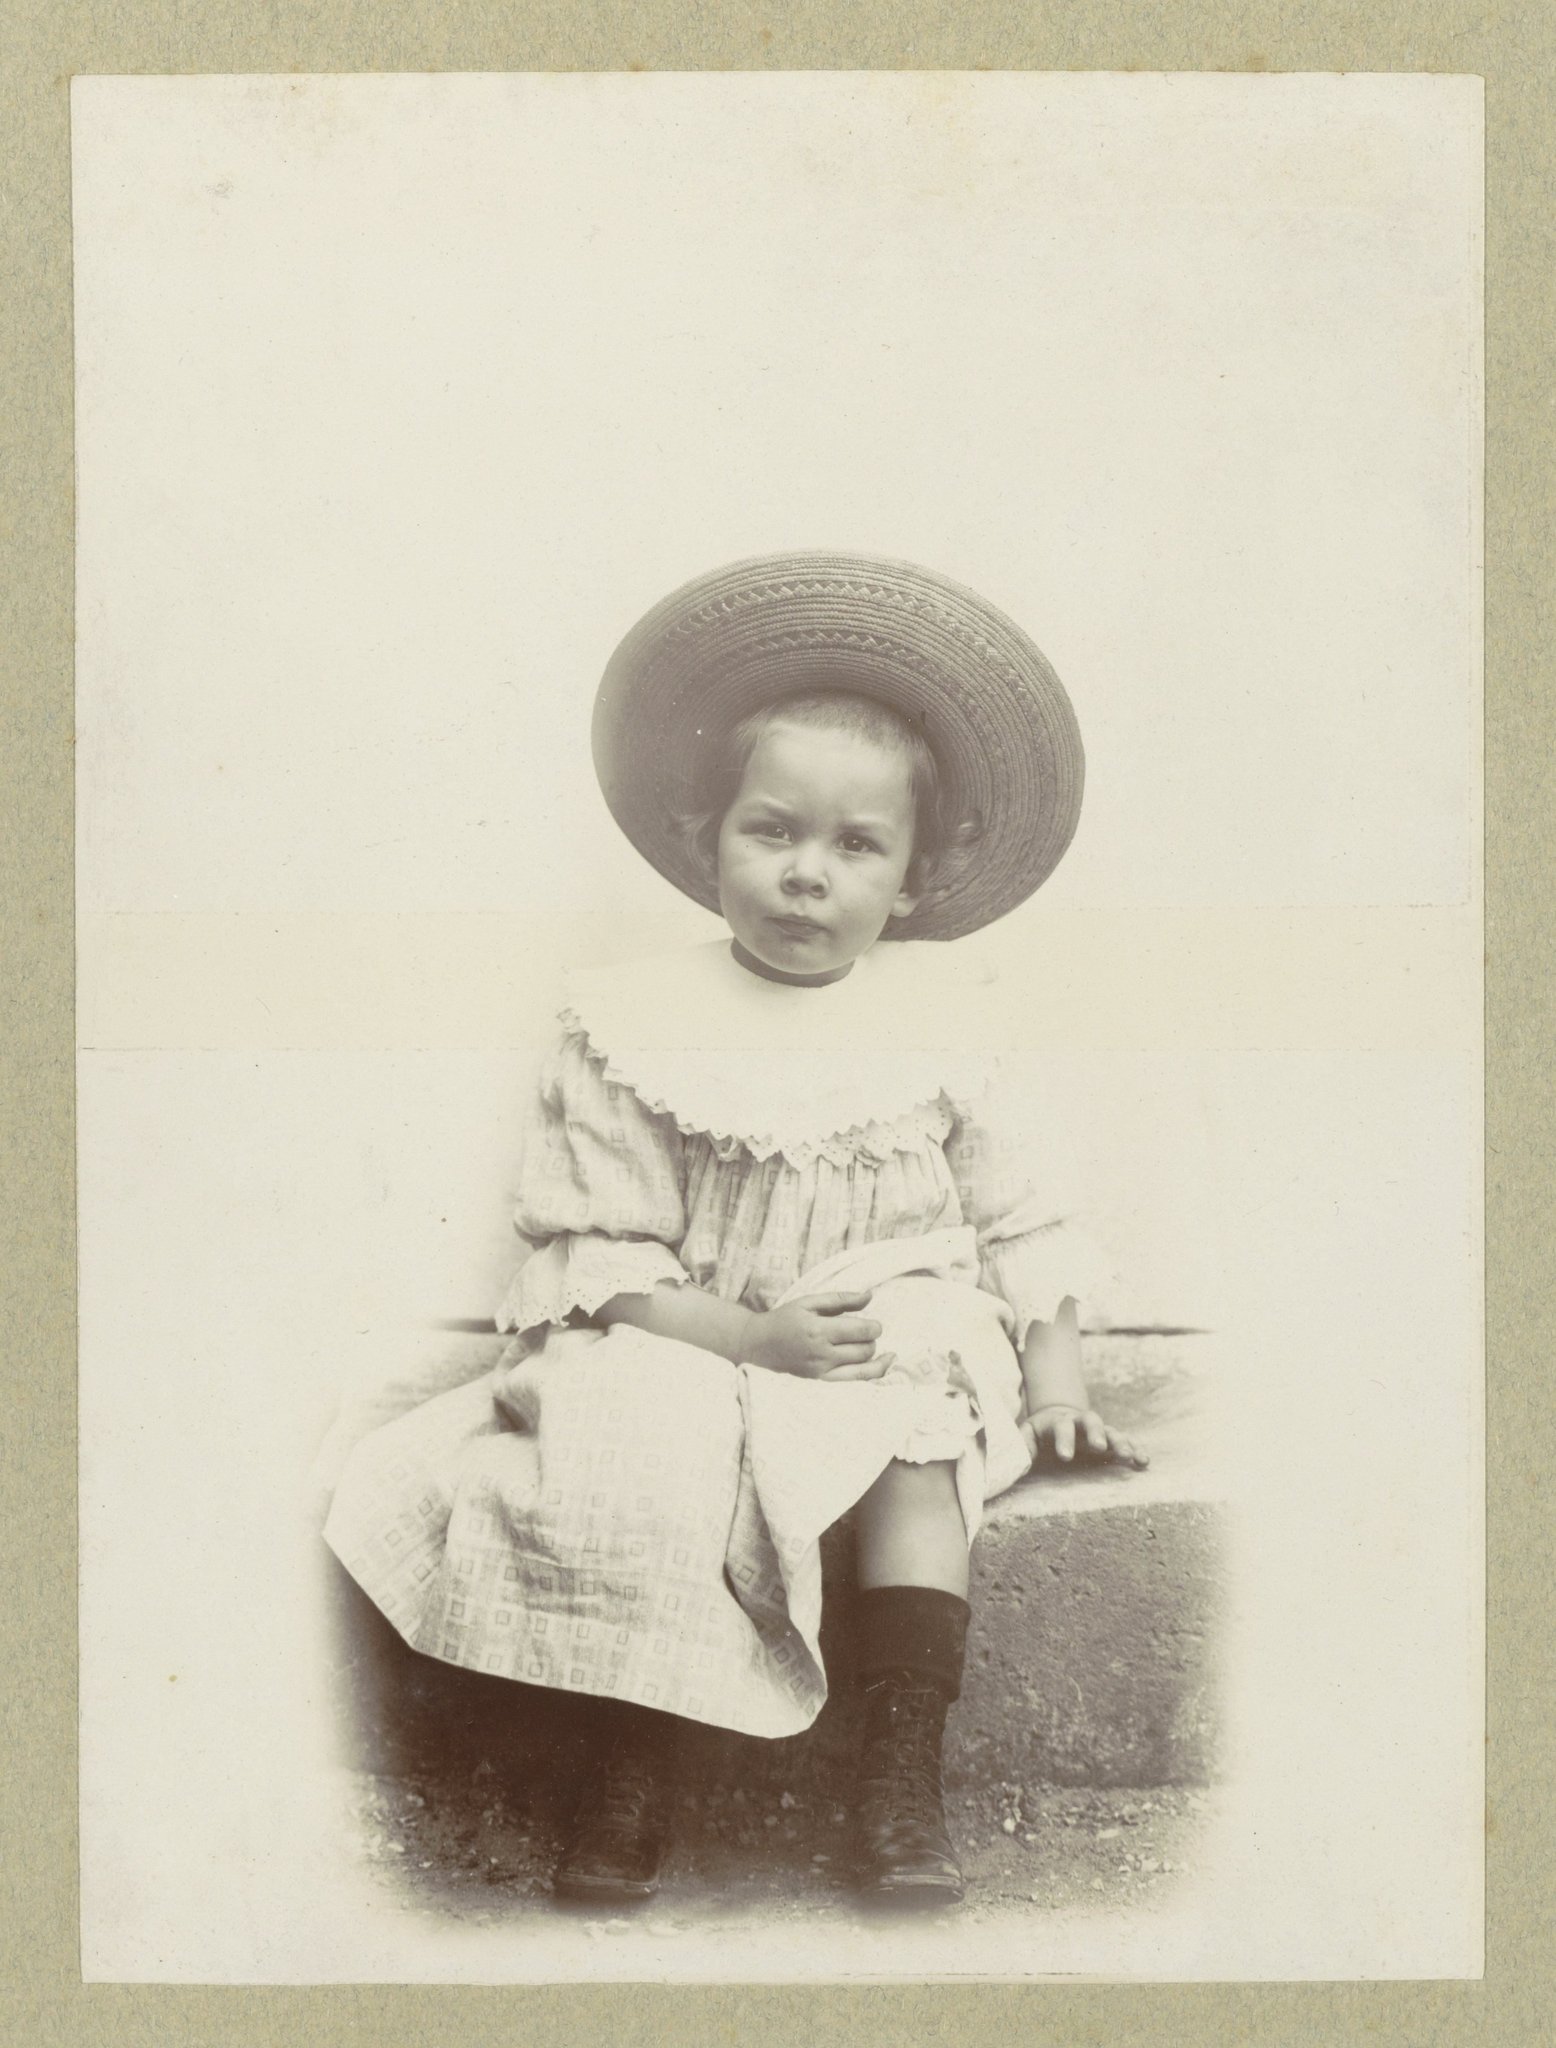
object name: photograph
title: Portret van een kind met een jurk en een zonnehoed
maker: Anonymous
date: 1885-1914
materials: photographic support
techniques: gelatin silver print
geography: france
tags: child, france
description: Onderdeel van Fotoalbum met familiefoto's.